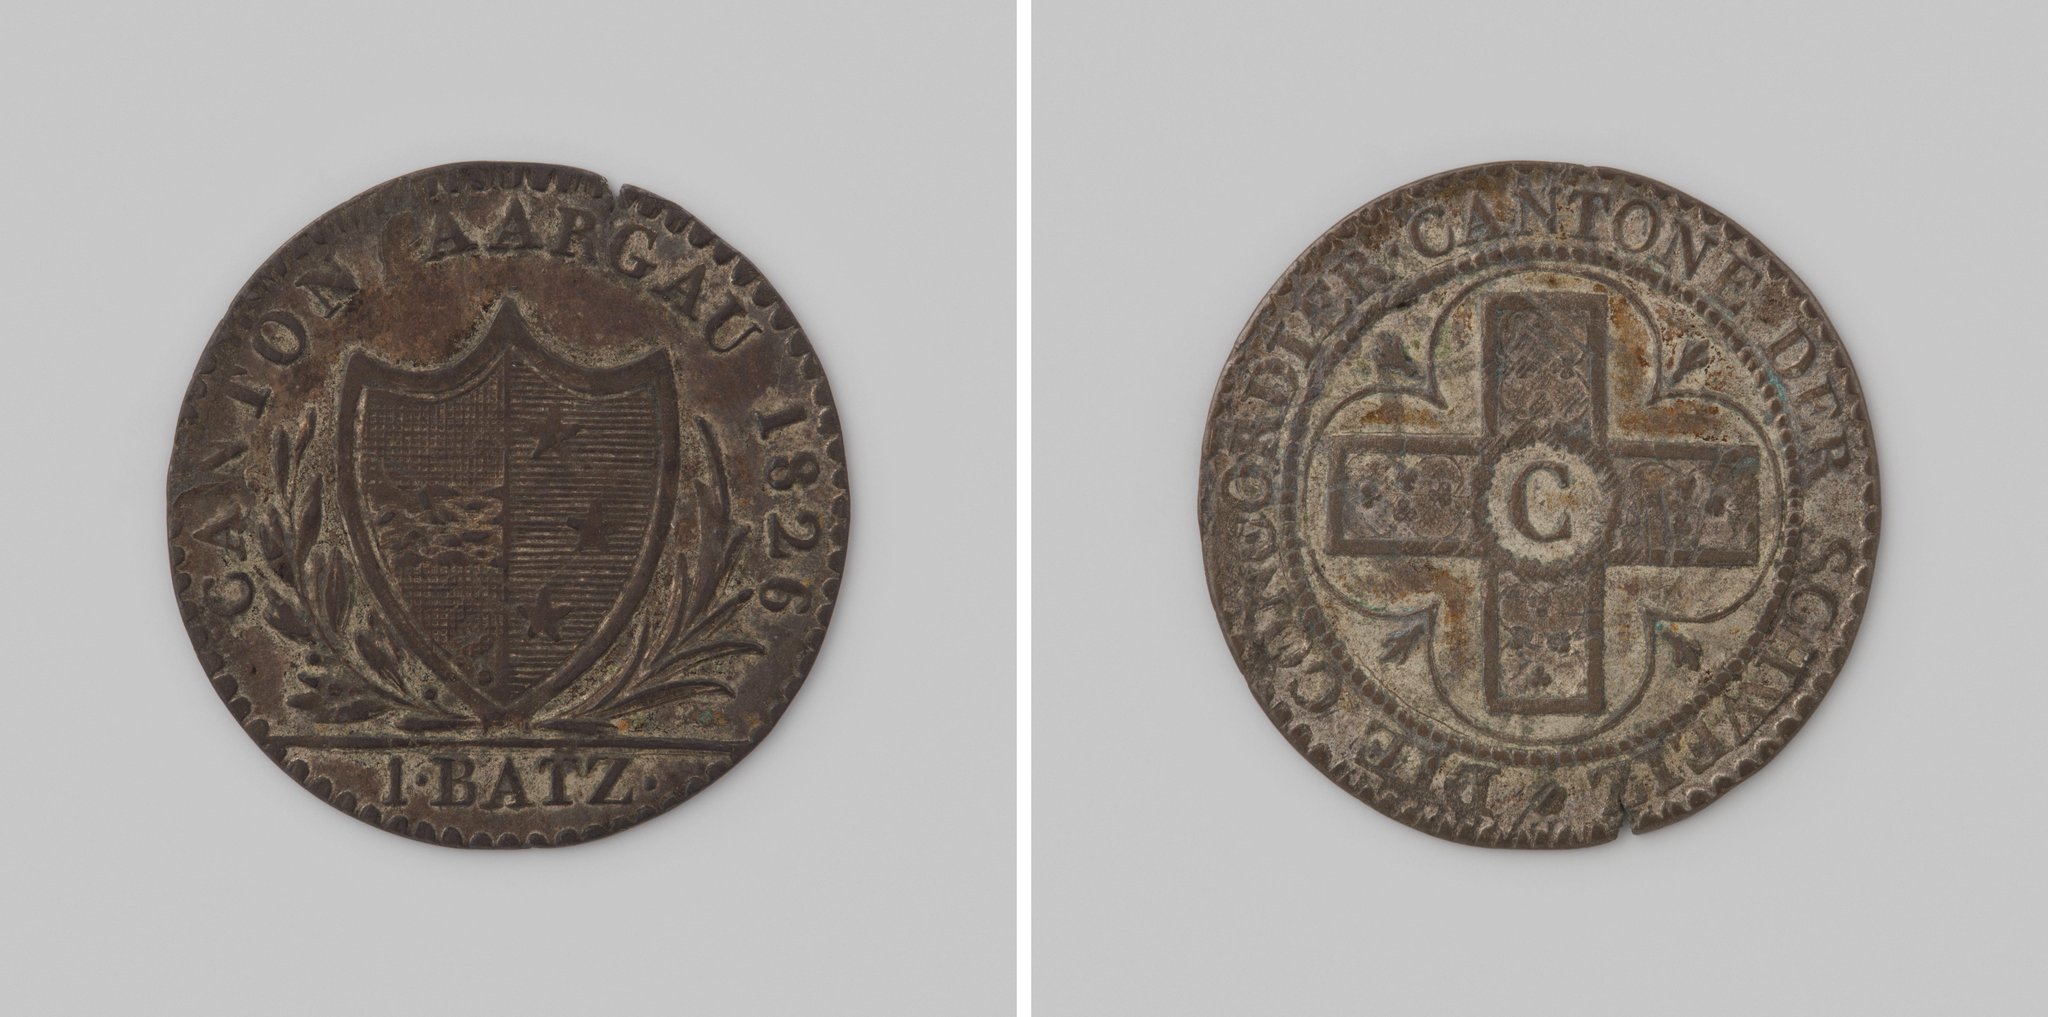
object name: coin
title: Kanton Aargau, batzen, 1826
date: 1826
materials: silver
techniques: striking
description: Zilveren munt. Voorzijde: tussen twee samengebonden takken wapenschild. In afsnede waarde-aanduiding: 1. batz.. Keerzijde: binnen versierde vierpas kort kruis, waarvan de benen zijn versierd. In het centrum letter C [van Concordaat]. Gladde rand.